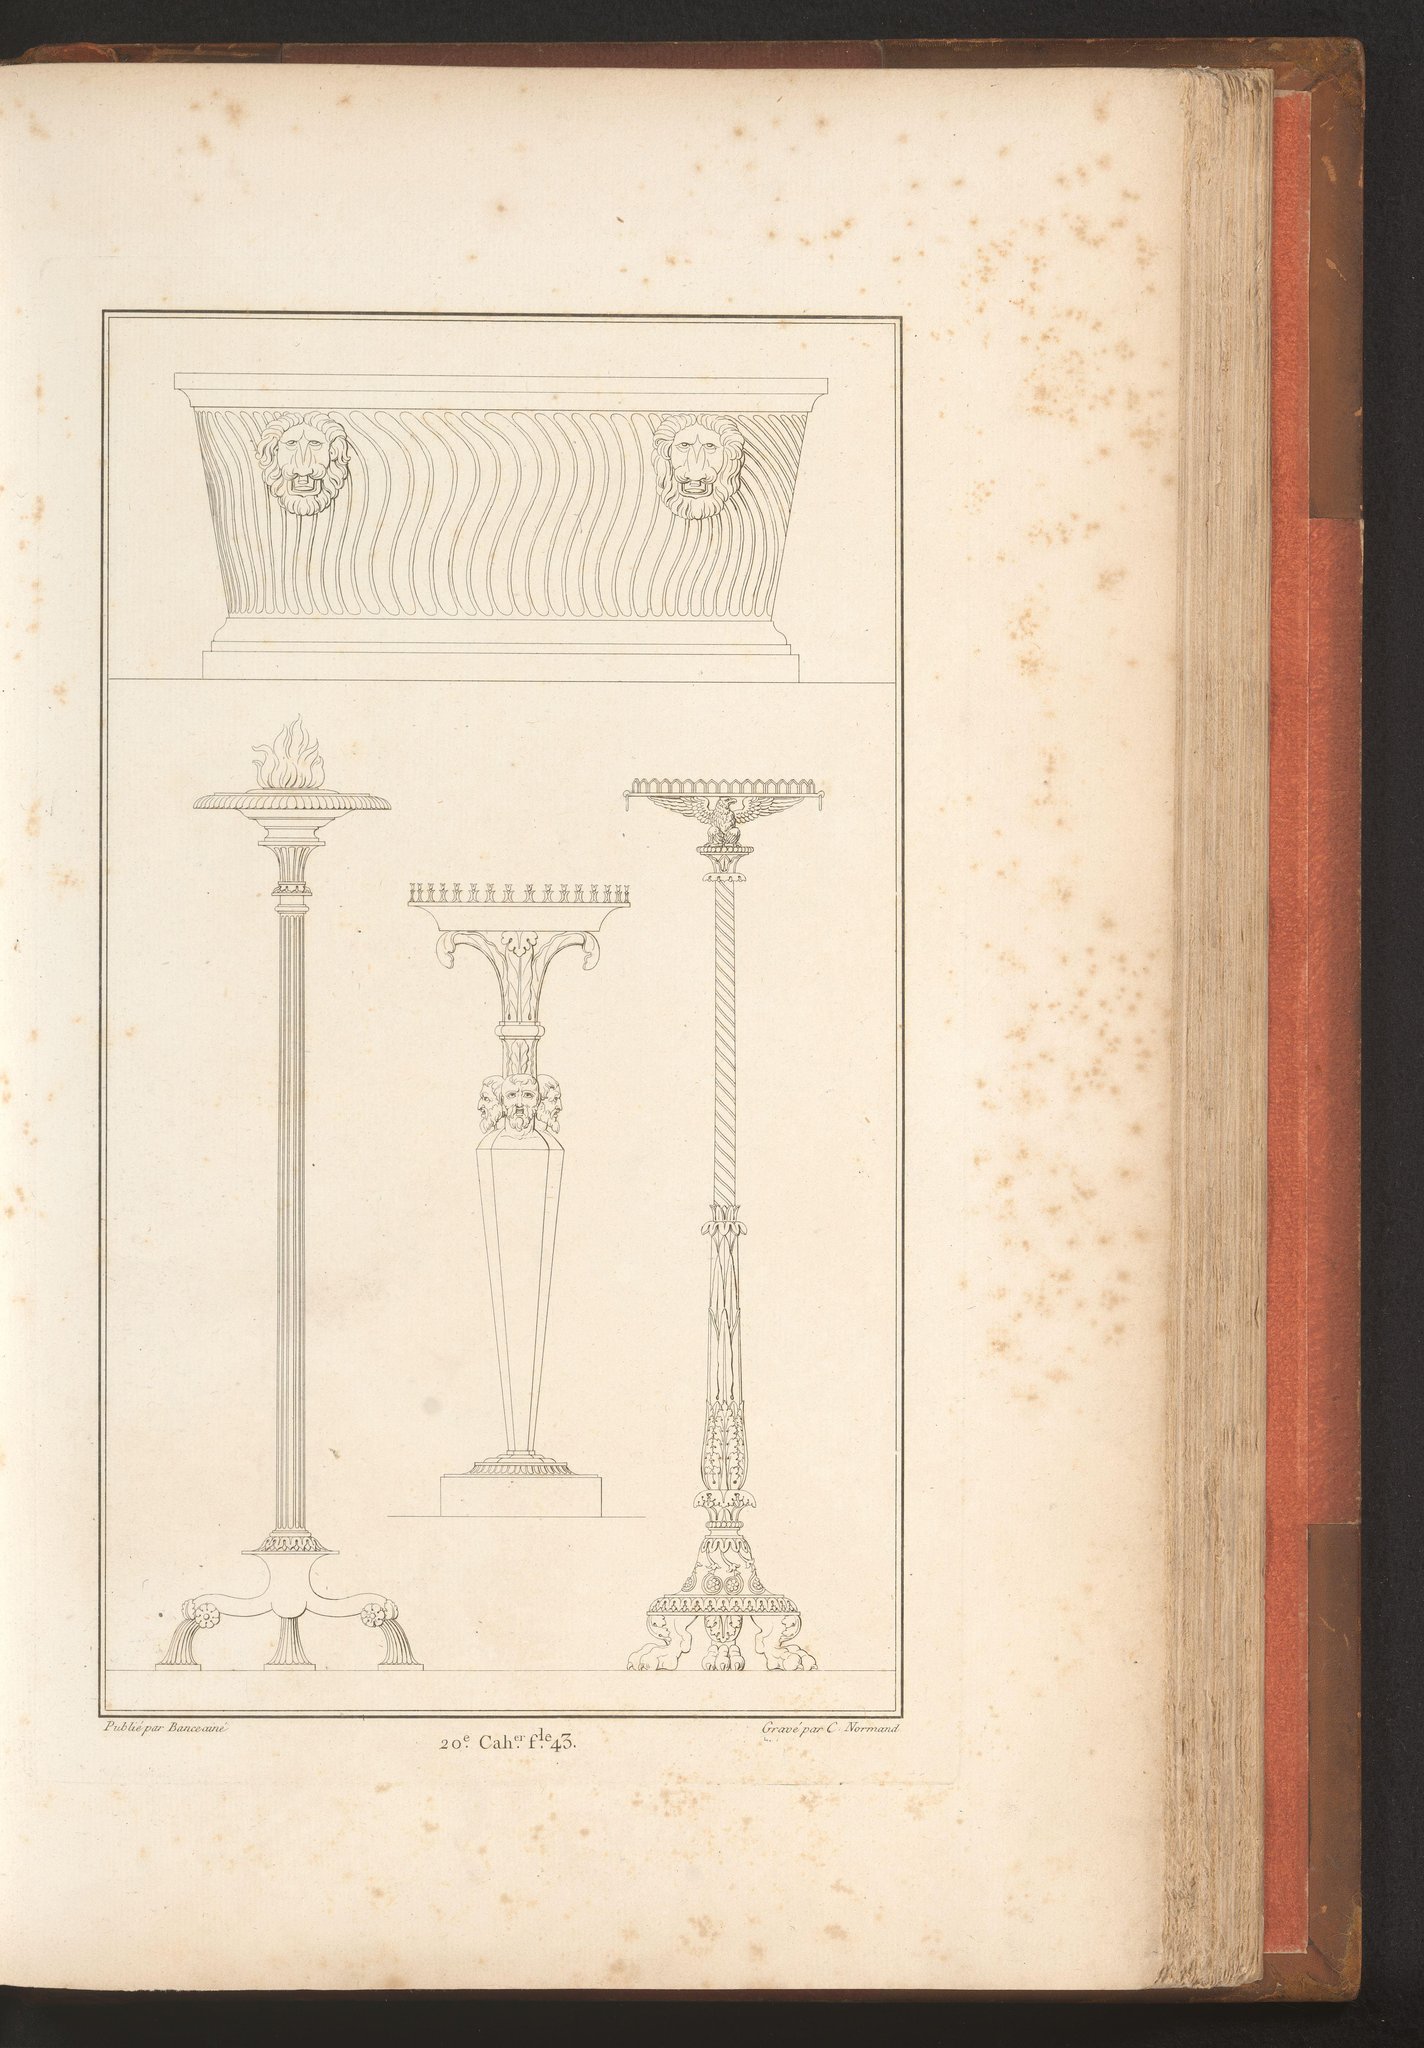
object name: ornament print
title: Drie gueridons en een tobbe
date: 1820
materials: paper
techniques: etching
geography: paris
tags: decorative furniture, ornaments ~ art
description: Ornamentprent met drie gueridons en een tobbe. Onderdeel (20e. Cah.er f.le 43) van het prentalbum met twee series van in totaal 138 ornamentprenten door Beauvallet en Normand, 'Fragmens d'Ornemens dans le Style Antique'.